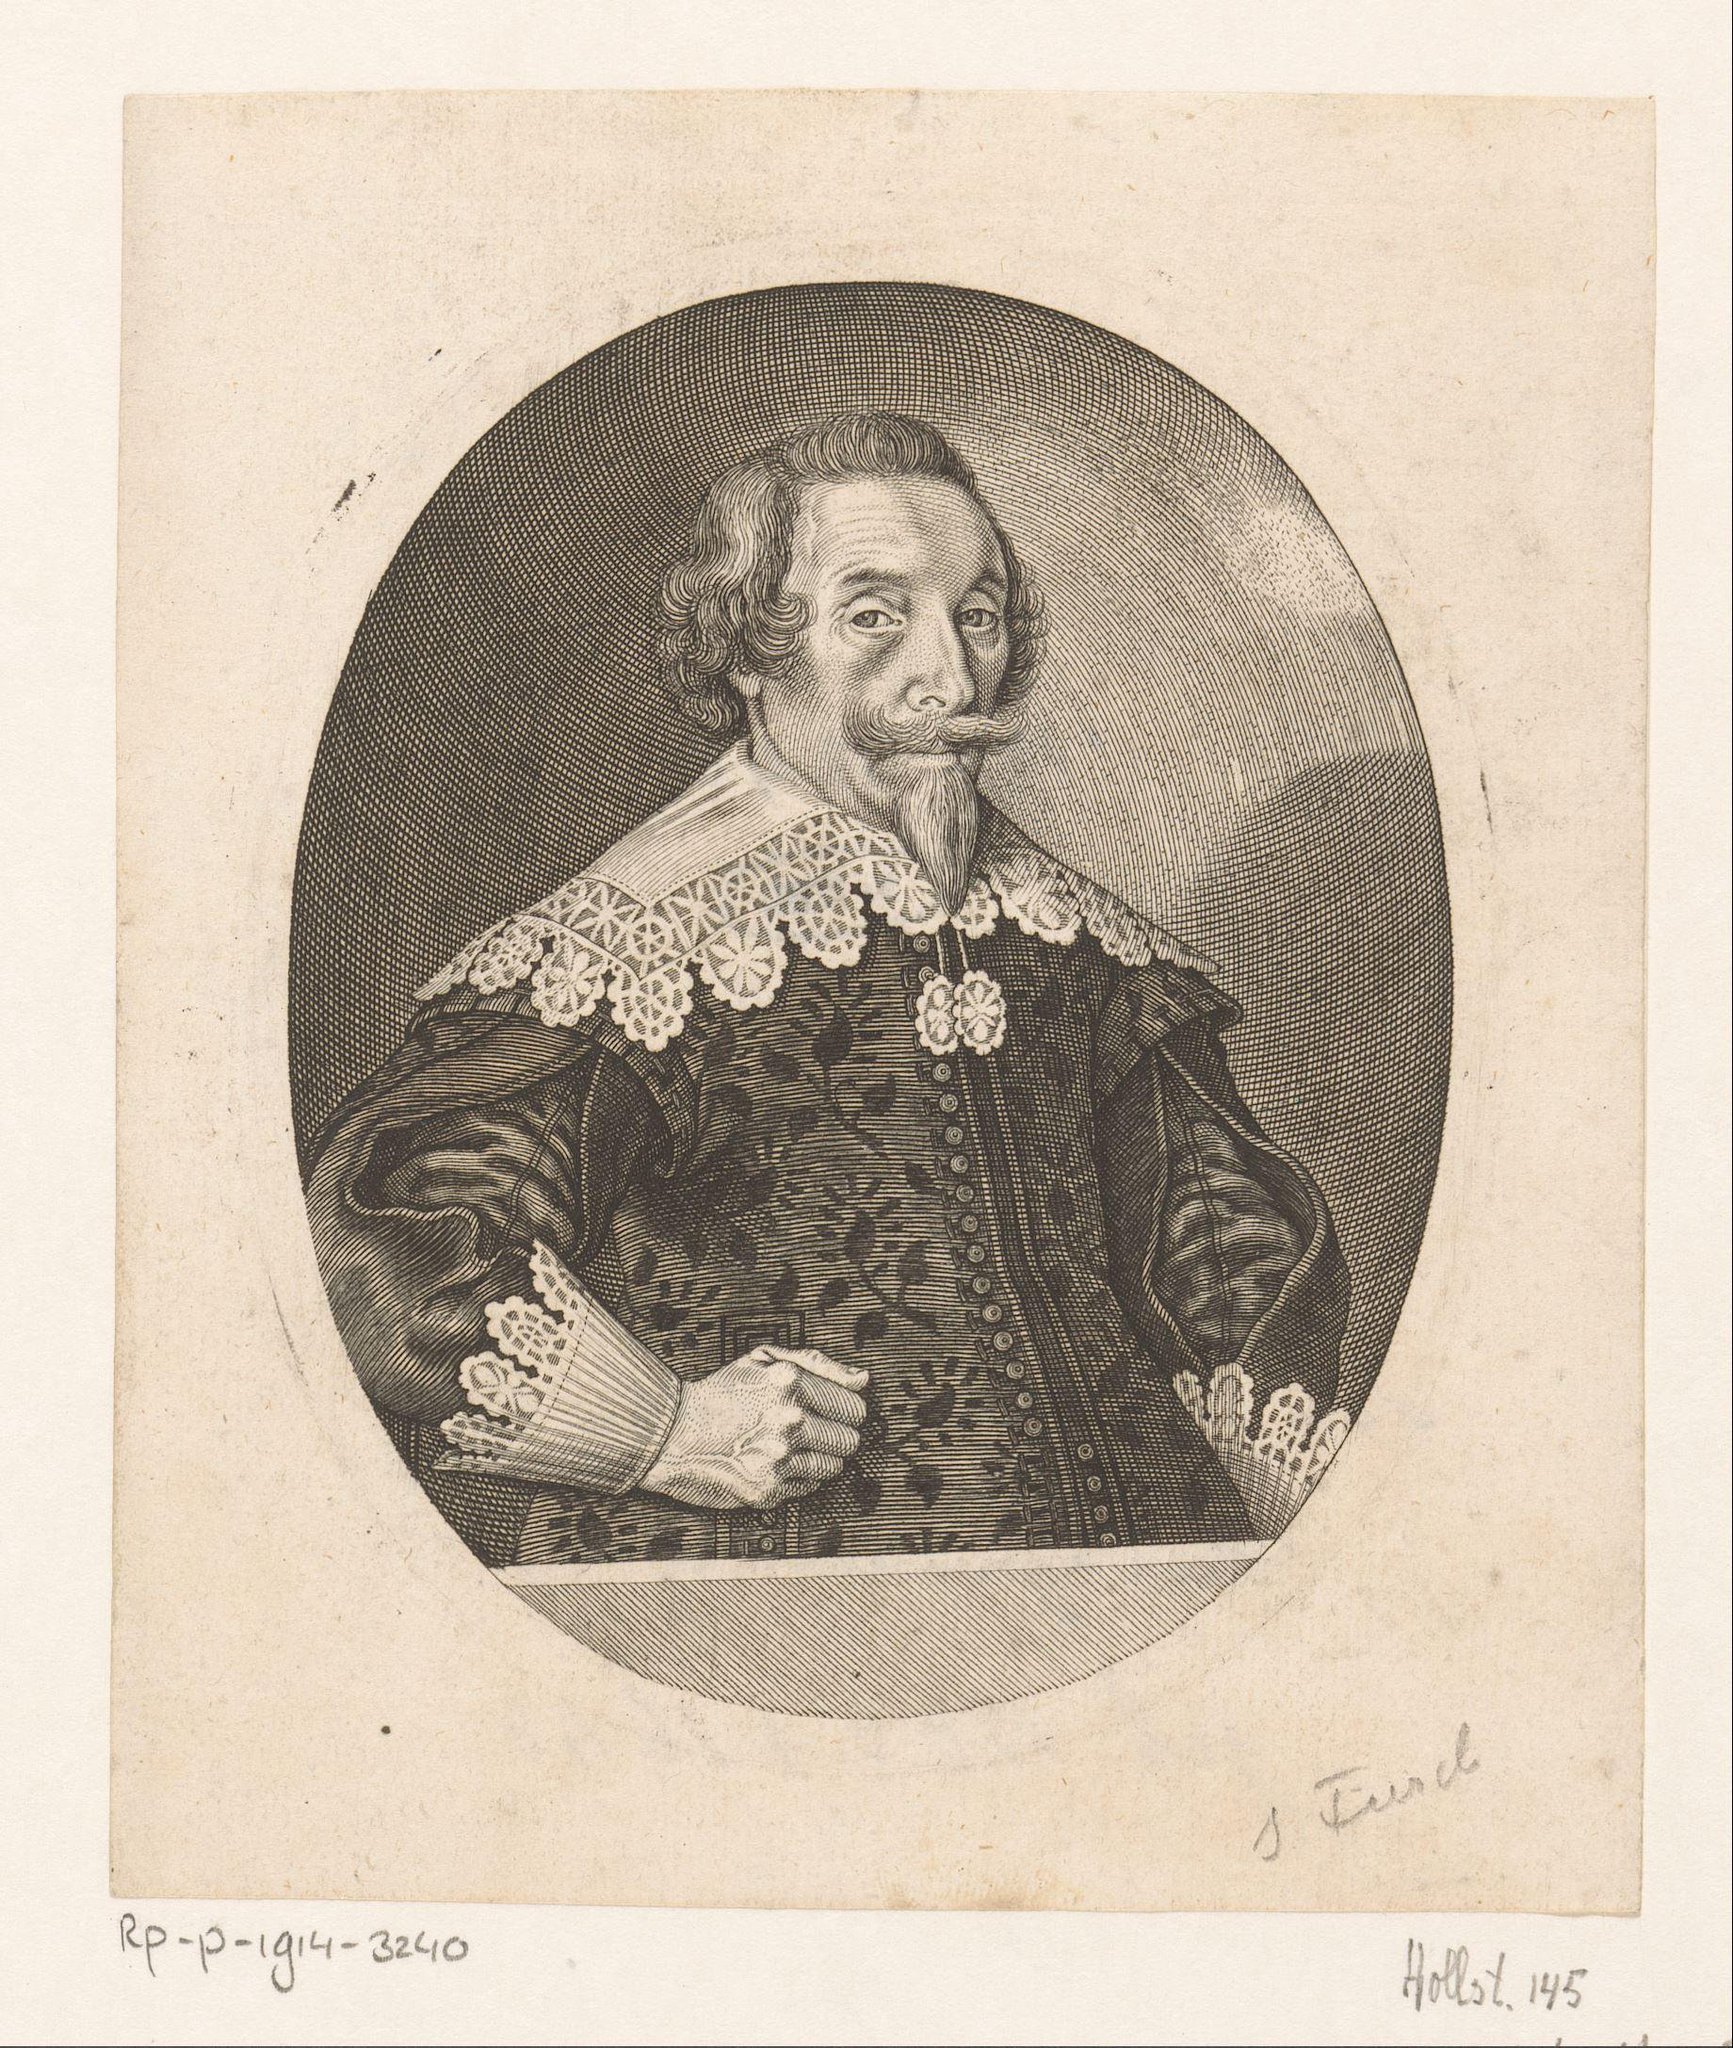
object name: print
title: Portret van Johann Schwind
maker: sebastian furck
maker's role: print maker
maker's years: 1600-1655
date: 1610-1648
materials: paper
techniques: engraving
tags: historical persons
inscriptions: collector's mark: Lugt 2228